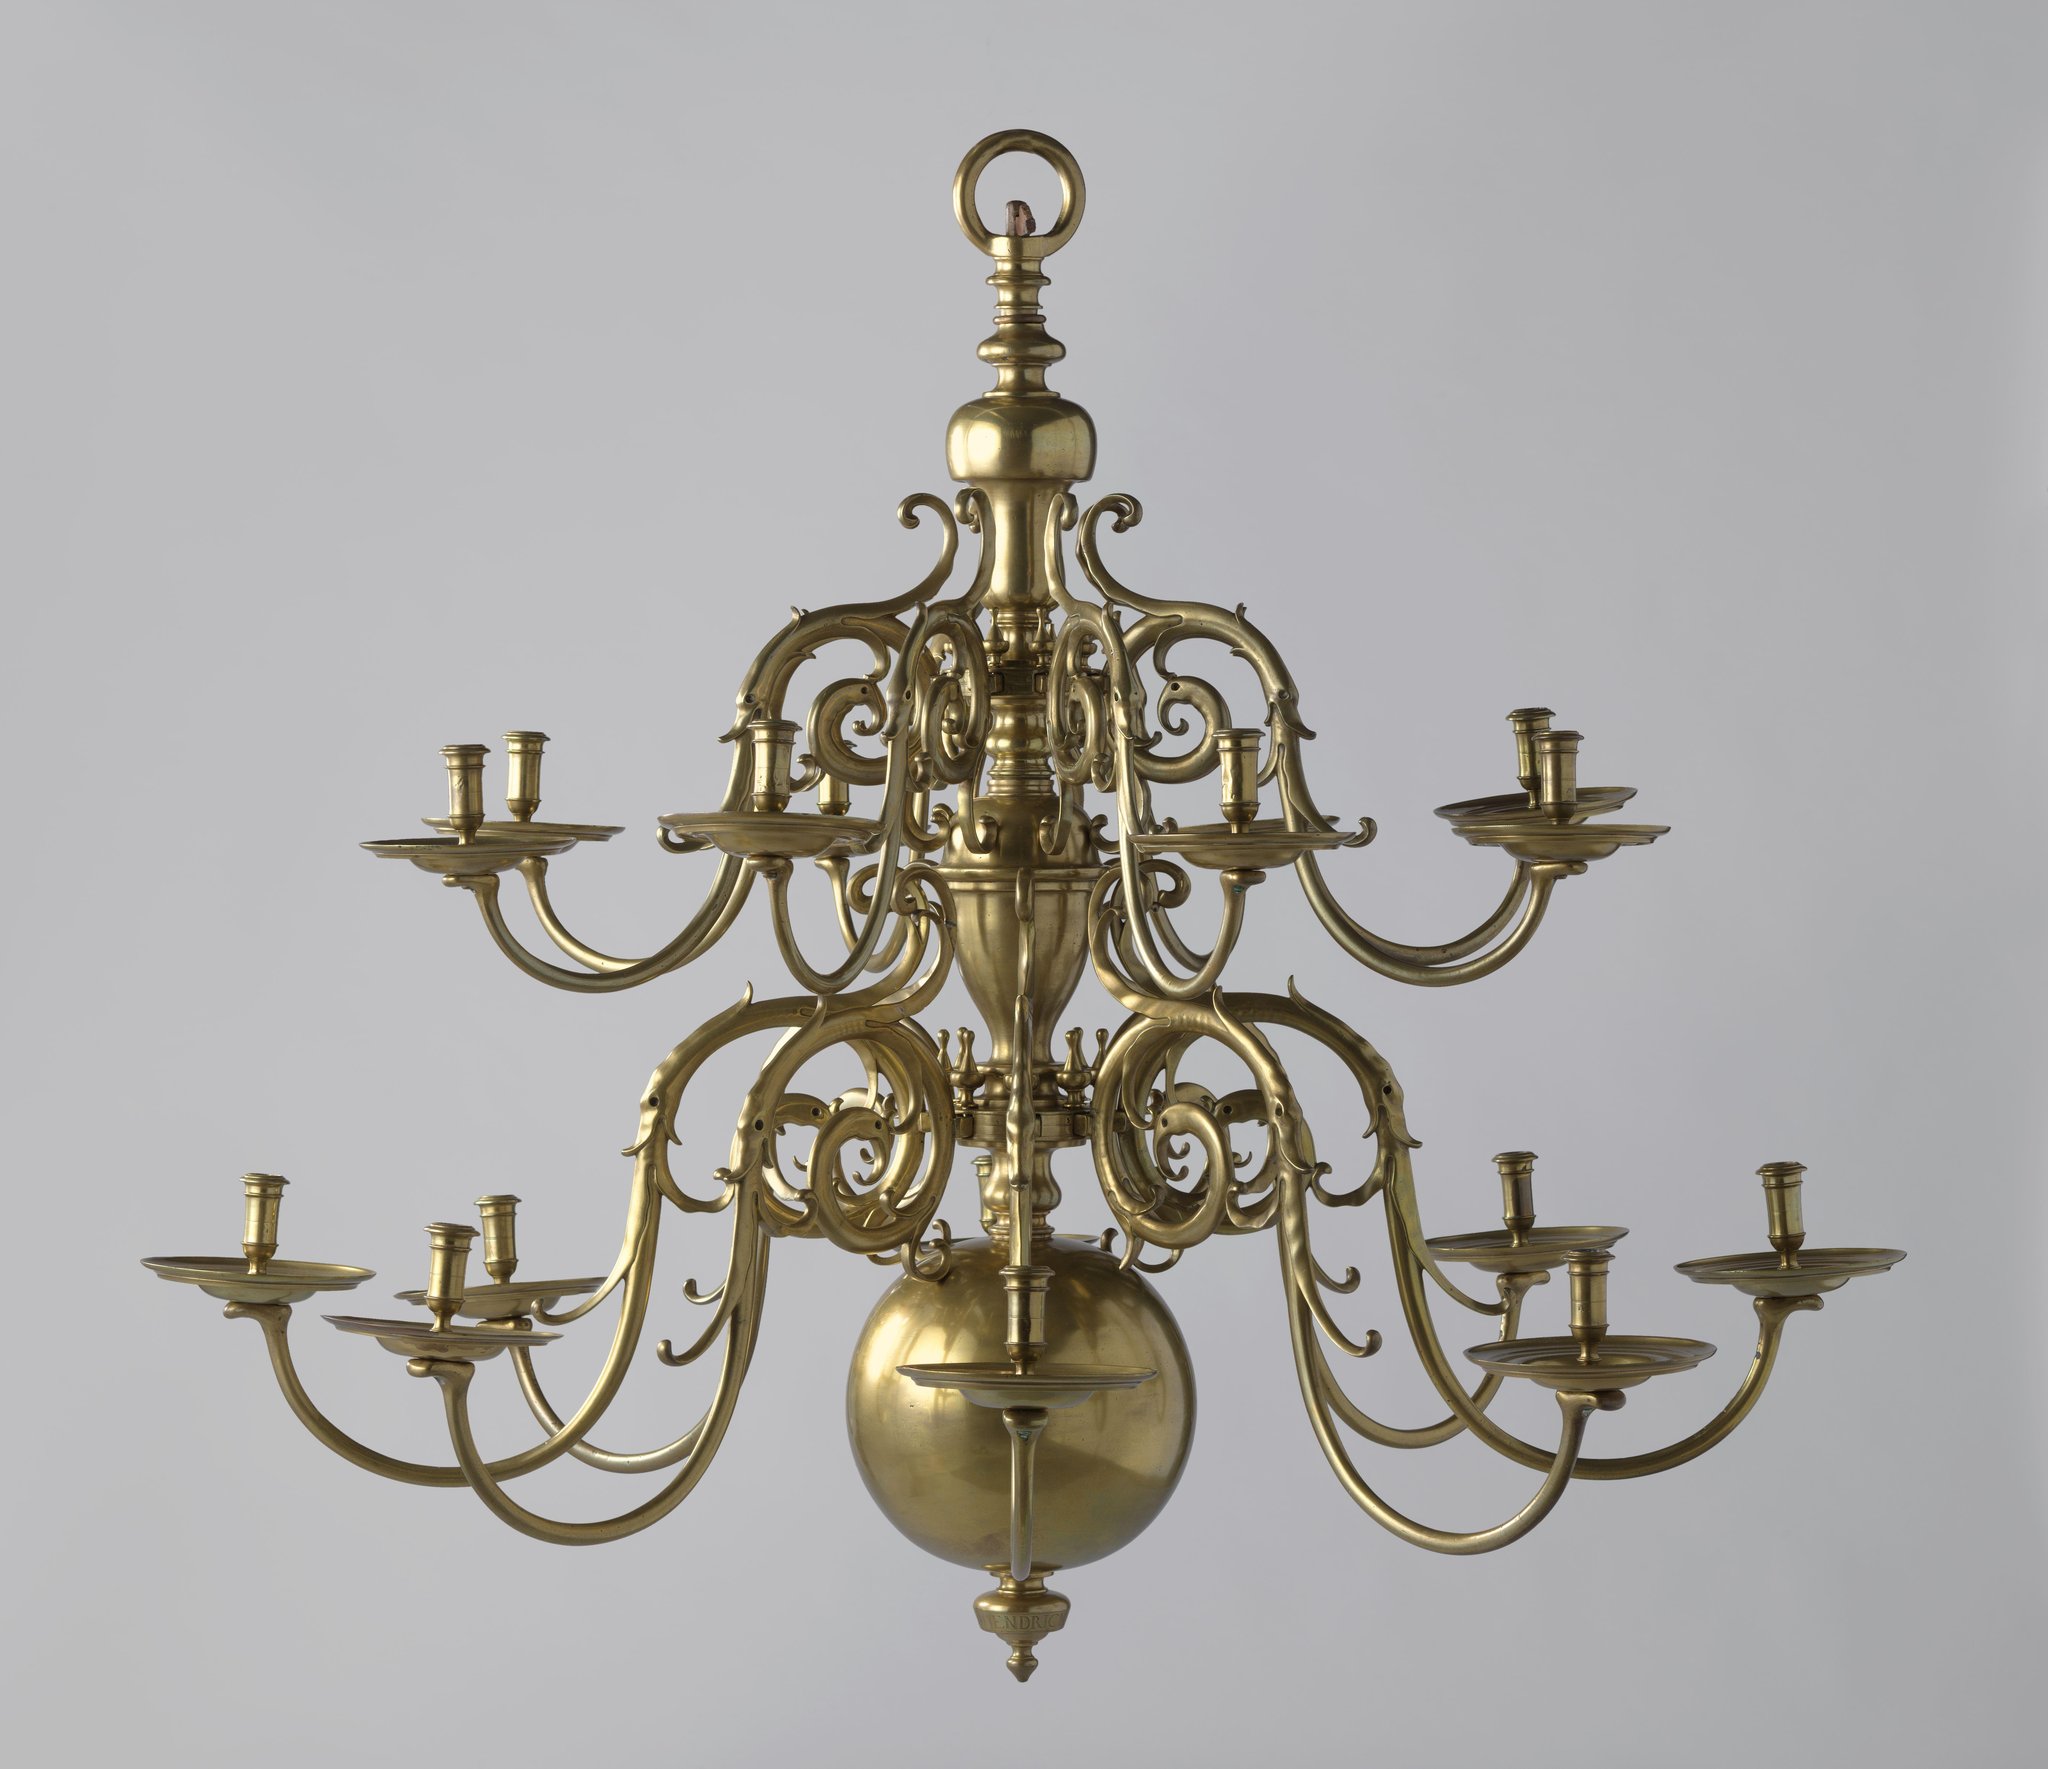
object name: chandelier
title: Arm met kaarsenhouder van kaarsenkroon van twee hoogten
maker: Anonymous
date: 1650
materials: brass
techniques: casting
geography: amsterdam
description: Kaarsenarm behorende bij een messing kaarsenkroon van twee hoogten. De S-vormige arm heeft een krul bij de aanzet, halverwege een dolfijnenkop en gaat naar buiten toe over in het platte verdikking met een schroefgat. Daarin is de kaarsenhouder met de vetvanger vastgezet. De vetvanger is aan de onderzijde geribd geprofileerd rond de opening en heeft een naar onder en een iets uitstekend randje. De cylindrische kaarsenhouder heeft een geprofileerde en een uitstekende rand, twee gegroefde ringen, een rib en een geprofileerd smaller onderstuk, dat overgaat in een uitsteeksel met een schroefdraad met een centergat. De pin om de arm te bevestigen is kegelvormig met een ronde knop bovenop. De vetvanger heeft een dichtgemaakt, rond gat, dat er op wijst dat de kaarsenkroon ooit geëlectrifieerd is geweest. Dit is de eerste arm van de bovenste standring, genummerd met het cijfer 3.